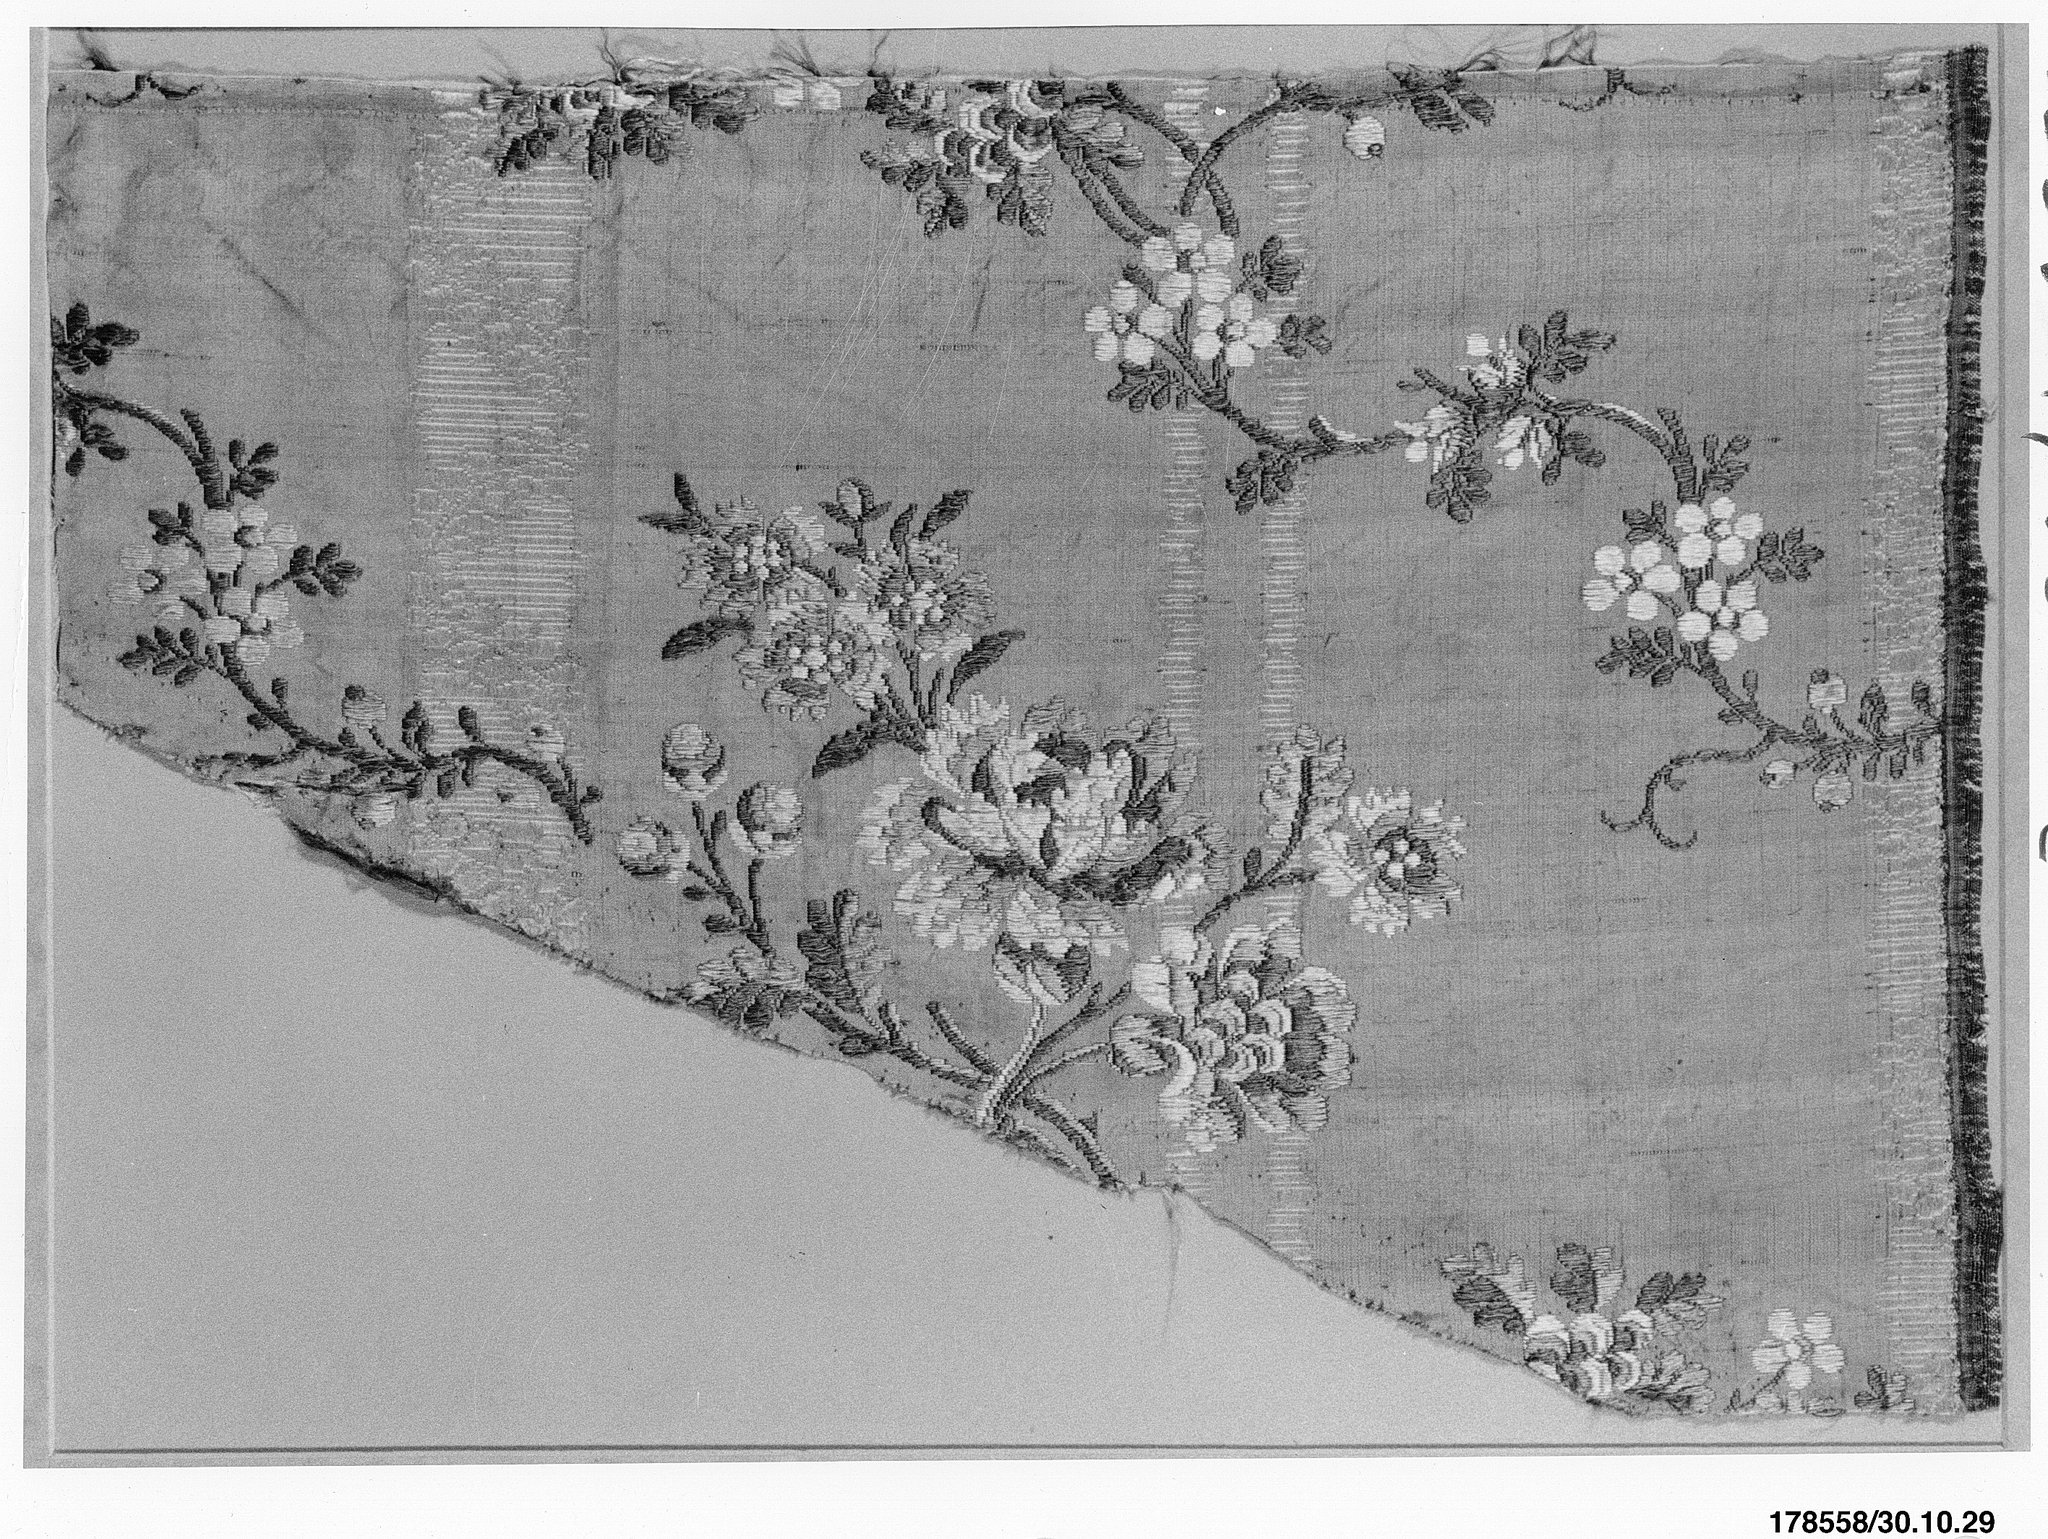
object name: piece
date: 1760-1770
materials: silk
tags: flowers,leaves